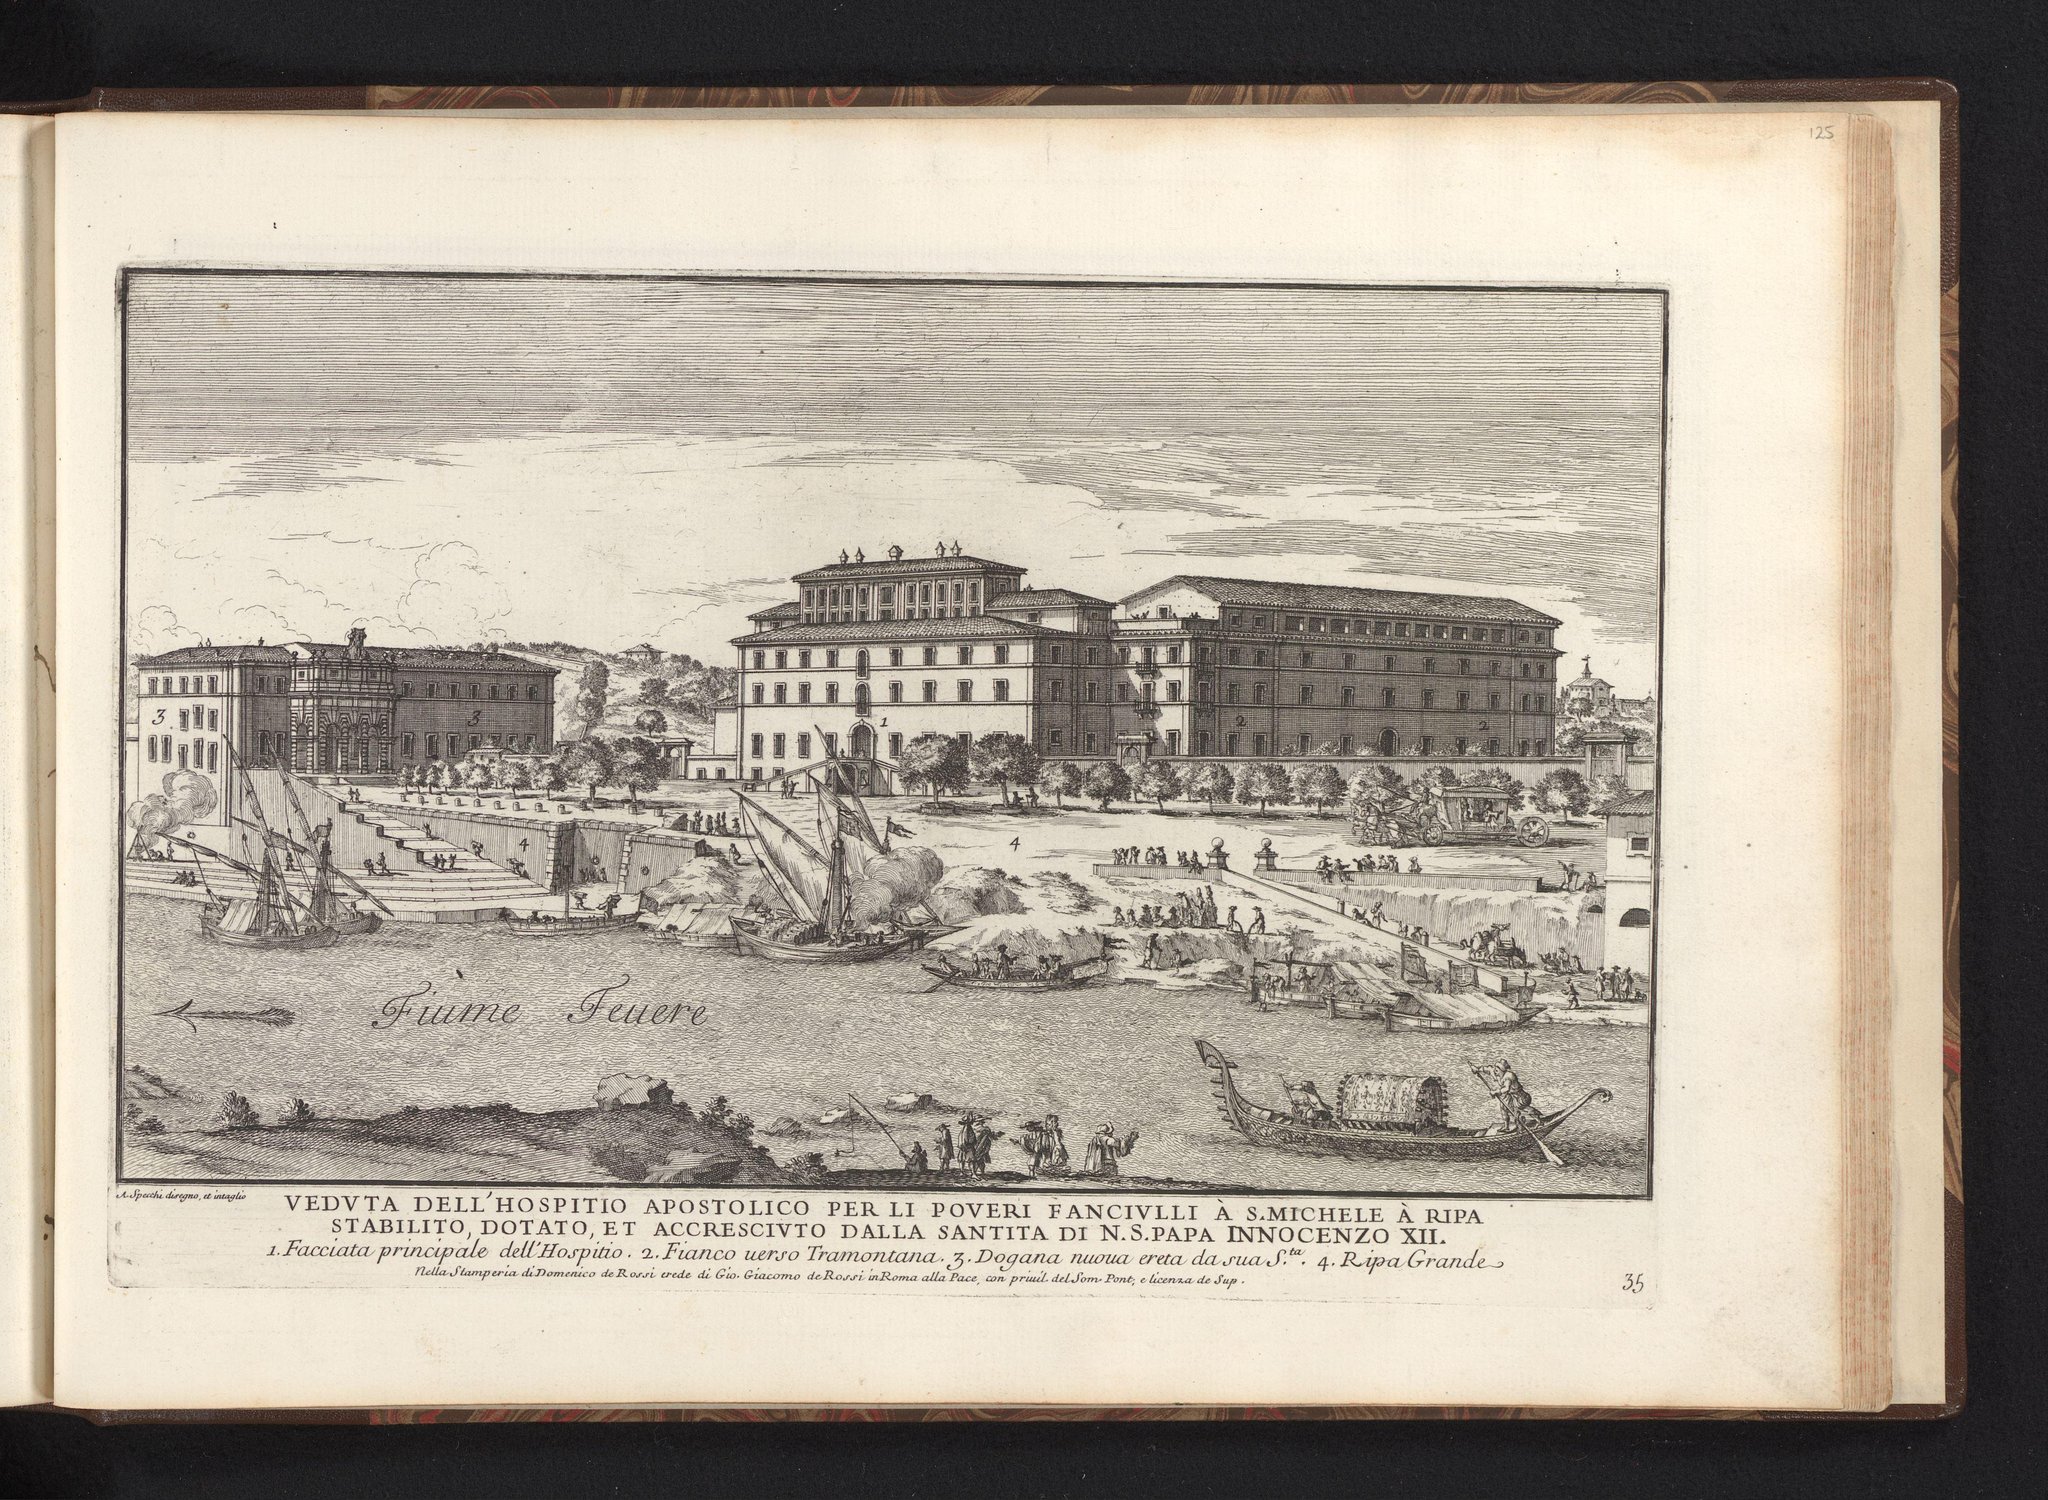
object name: album leaf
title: Ospizio di San Michele a Ripa Grande te Rome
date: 1699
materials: paper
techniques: etching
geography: rome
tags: harbour, city-view, and landscape with man-made constructions, river, hospital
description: Gezicht op de Porto di Ripa Grande in de Tiber te Rome met op de kade het Ospizio di San Michele a Ripa Grande. Titel en een verklarende lijst met nummers in de ondermarge. Prent maakt deel uit van een album.